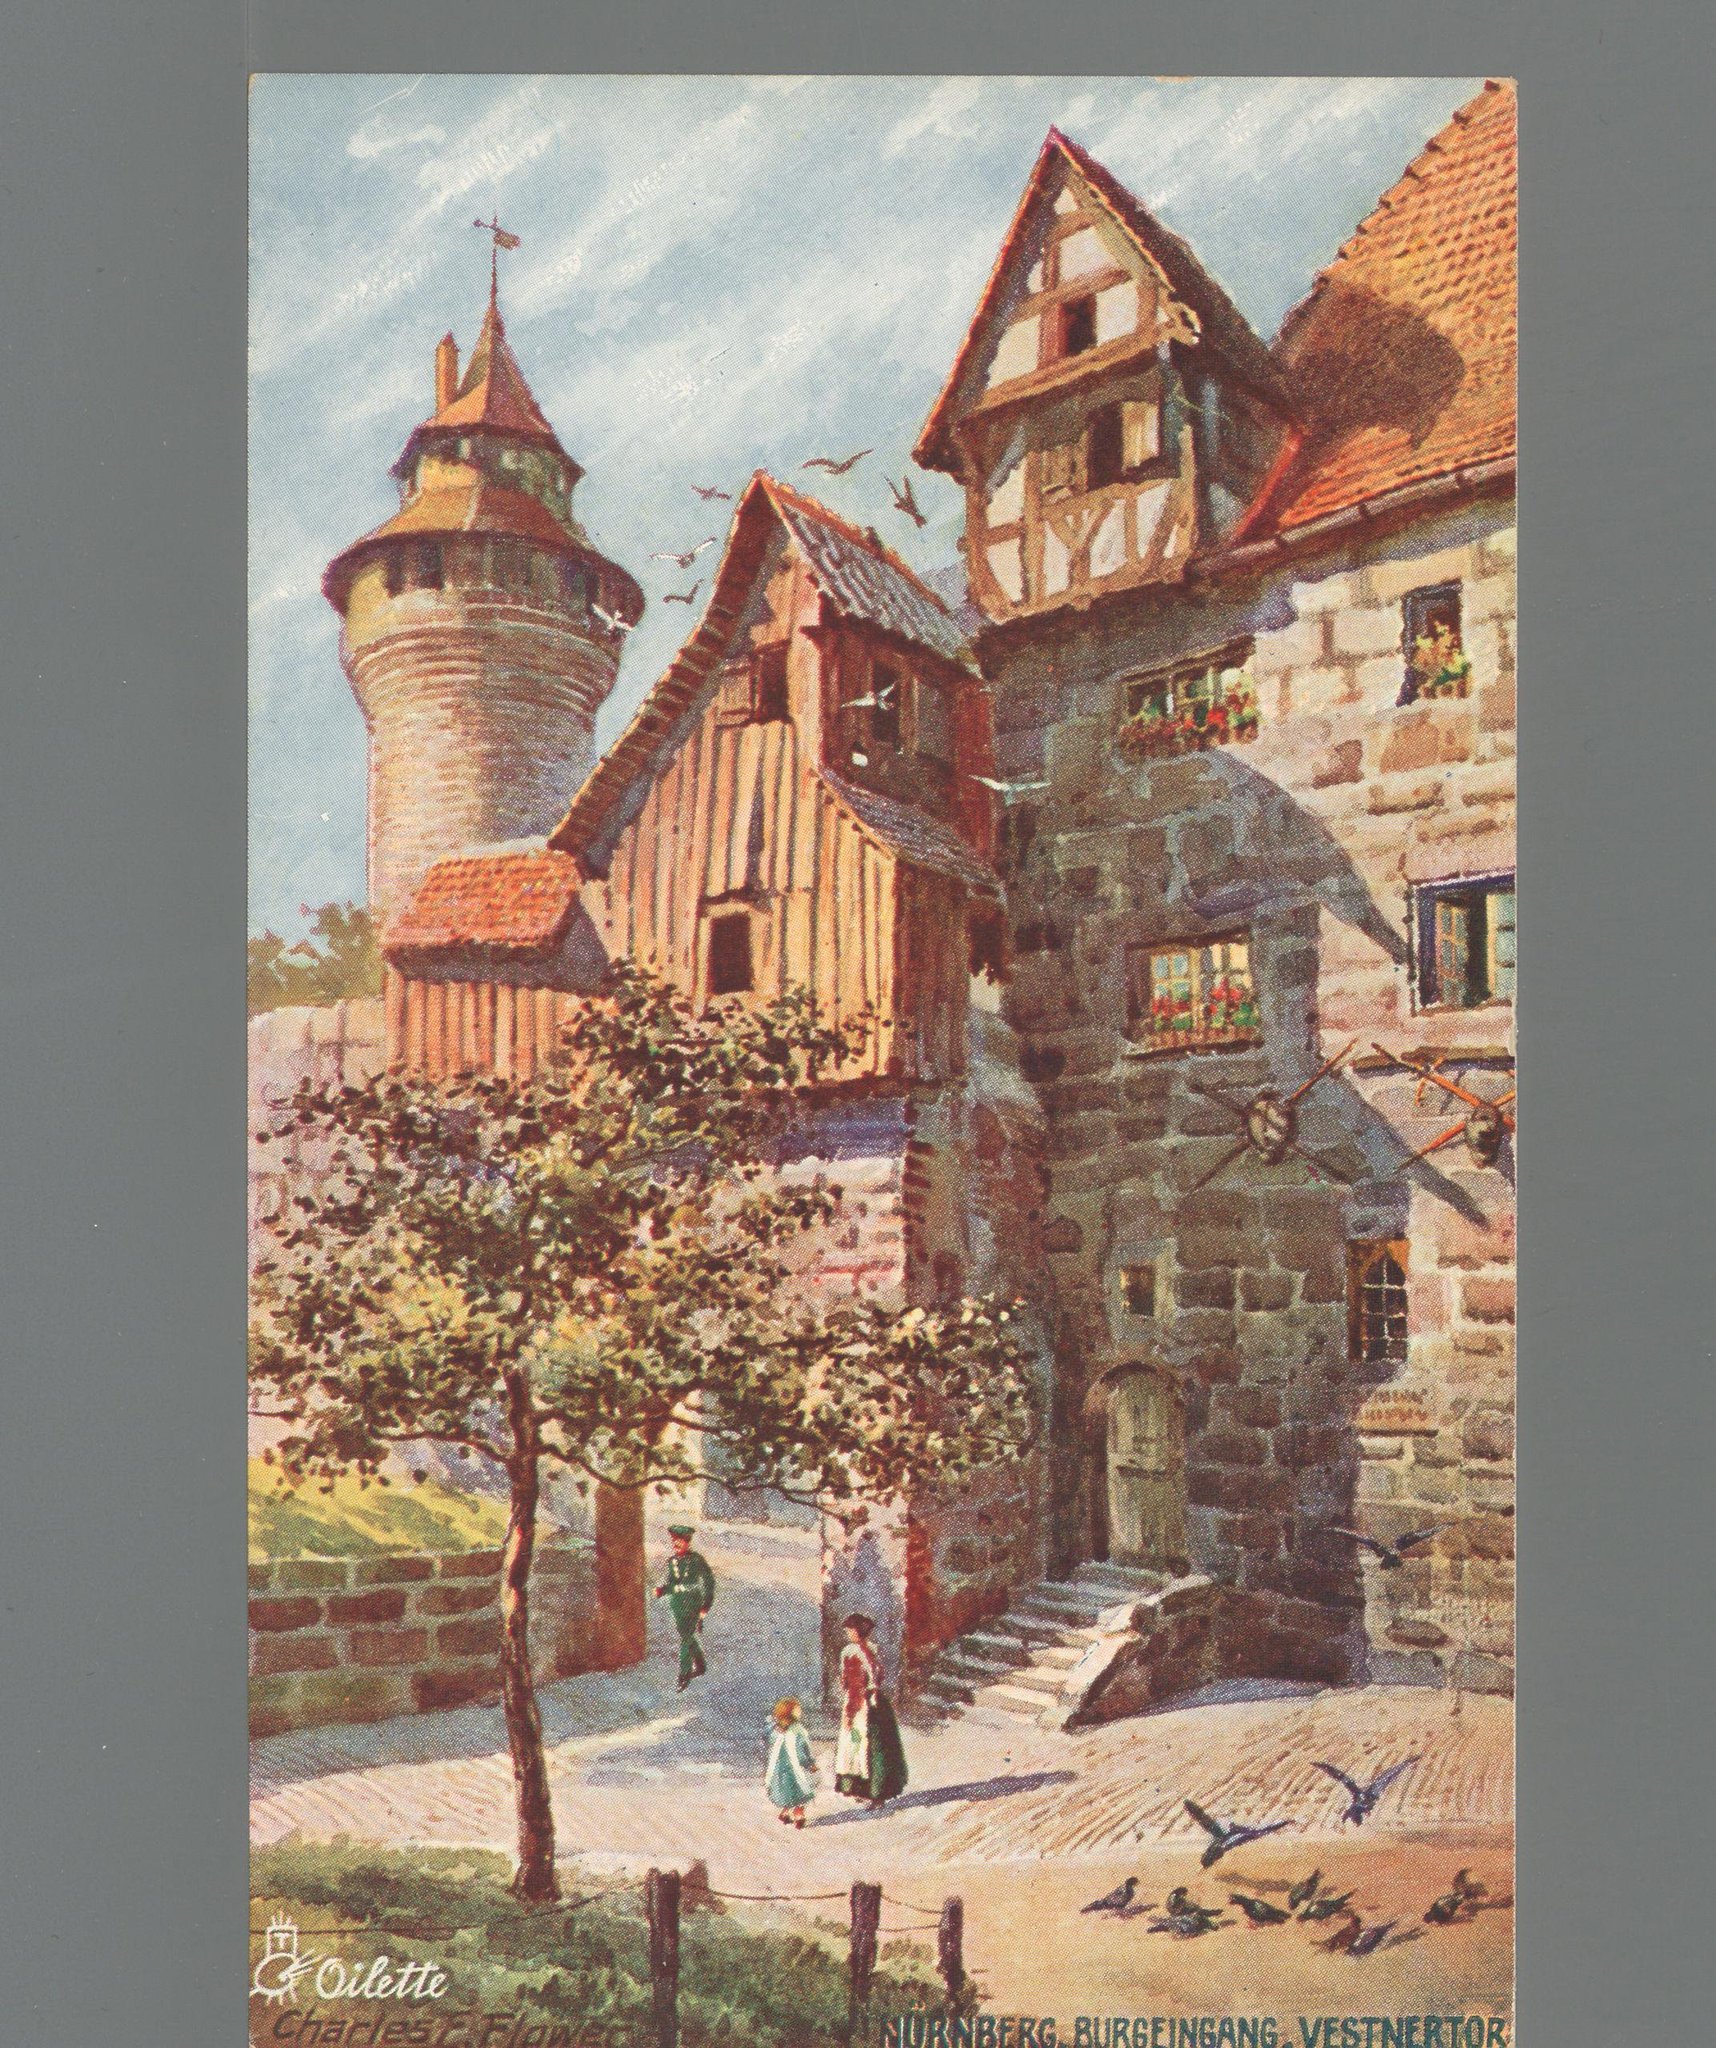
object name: photomechanical print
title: Nürnberg, Burgeingang, Vestnertor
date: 1908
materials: cardboard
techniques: writing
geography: london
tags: castle, gate, entrance